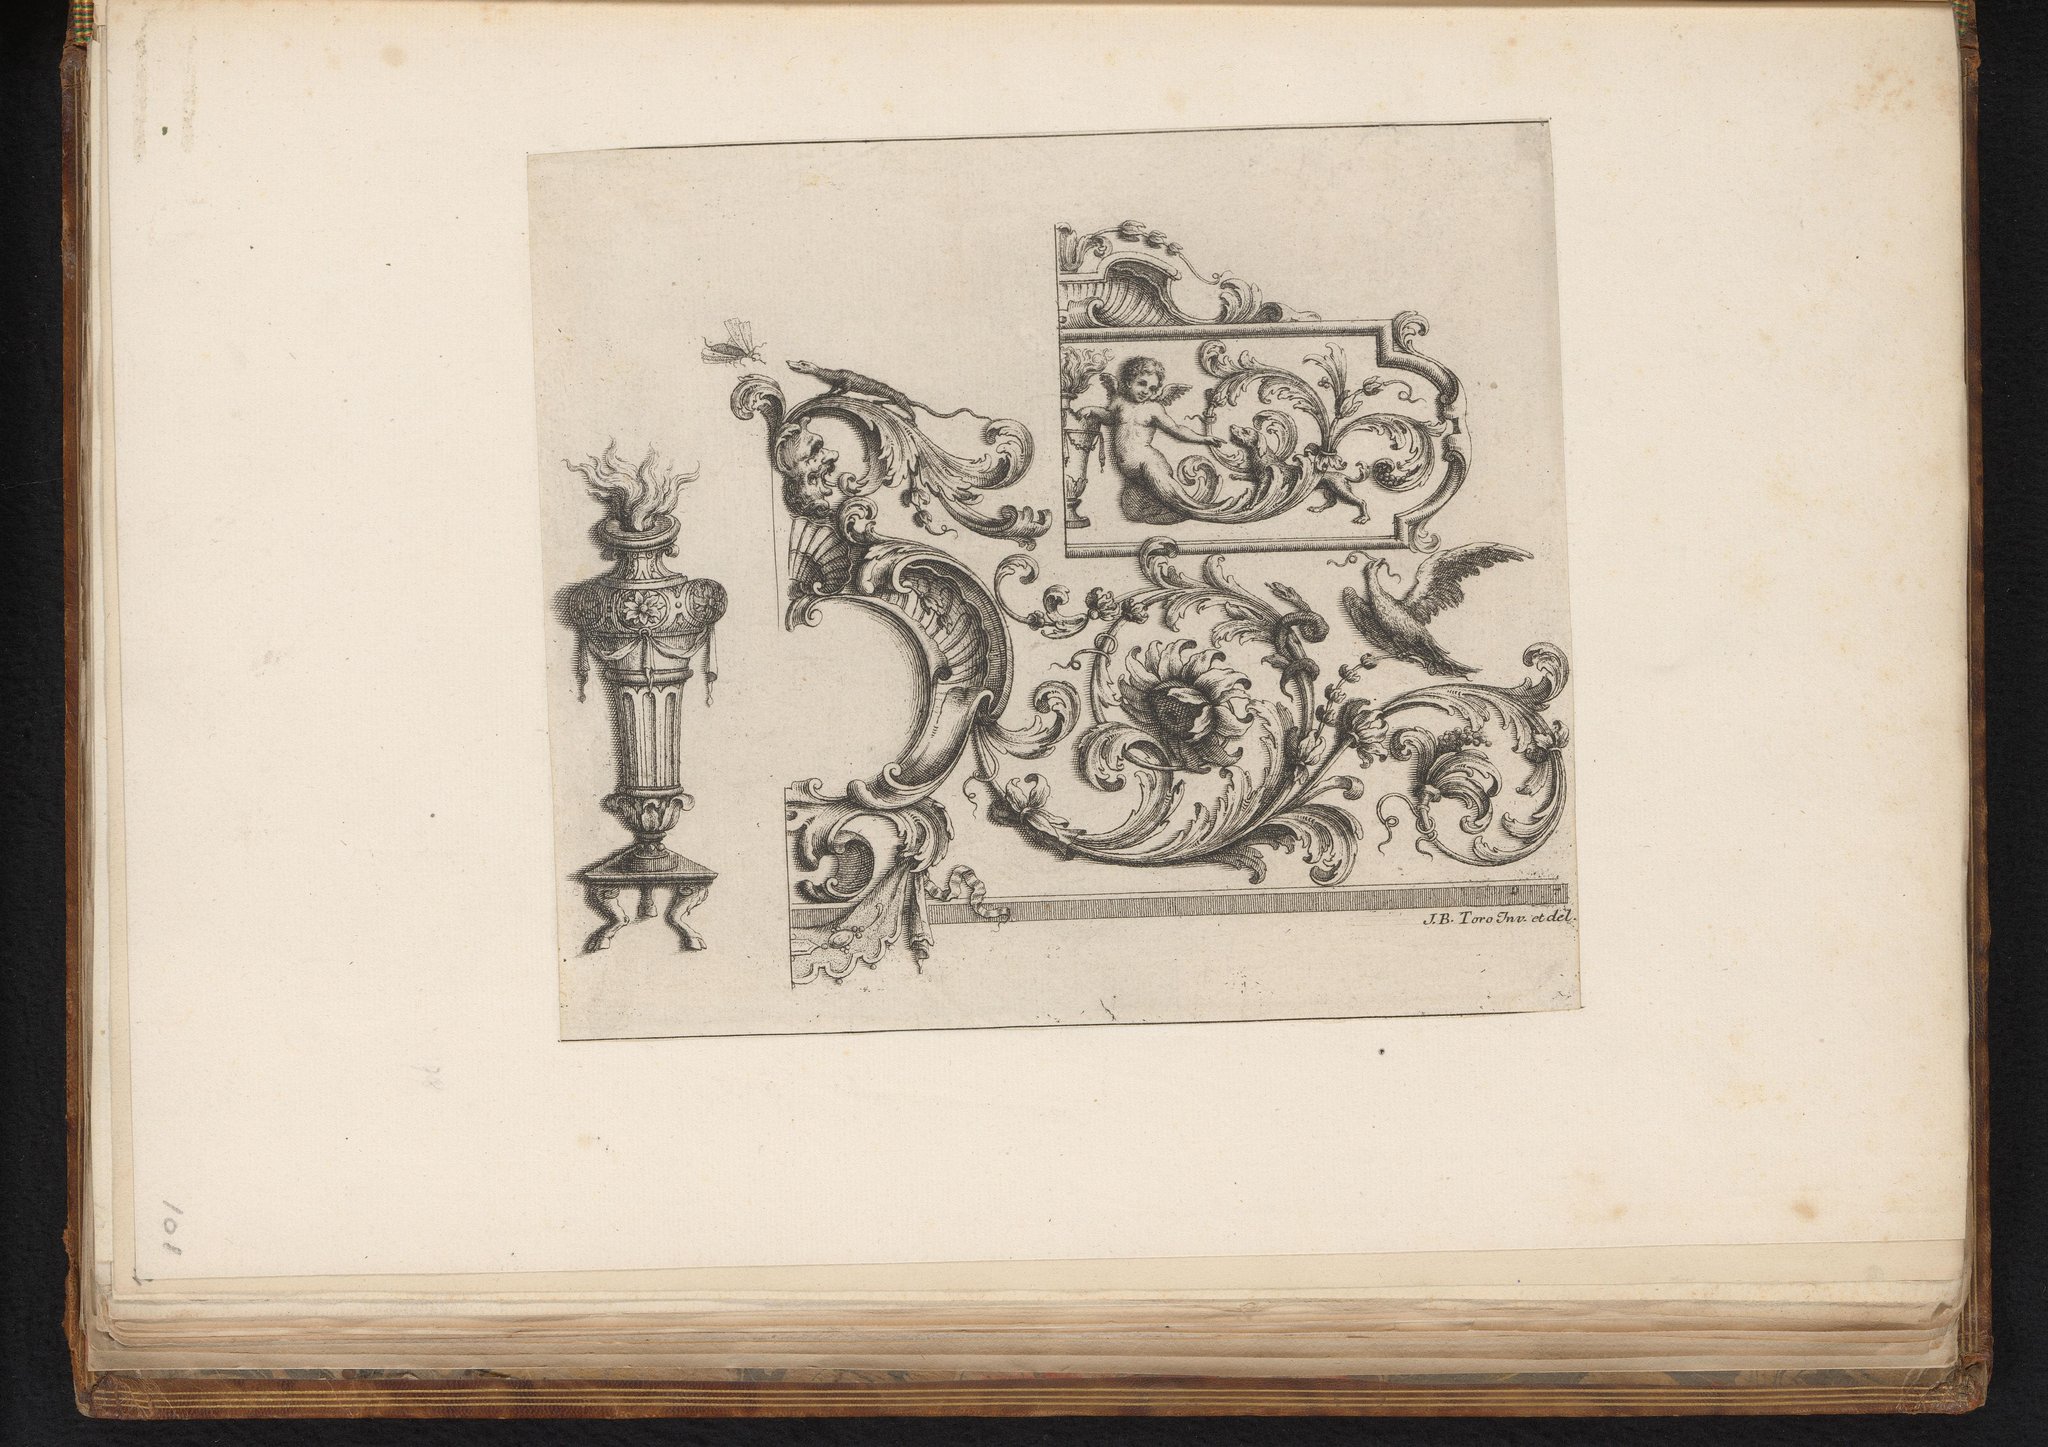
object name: ornament print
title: Ornamenten met plantmotieven en arabesken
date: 1682-1739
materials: paper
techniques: etching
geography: paris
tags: ornament ~ arabesque, ornament derived from plant forms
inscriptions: collector's mark: Lugt 2760, collector's mark: Lugt 2228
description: Prent maakt deel uit van een serie van zeven prenten.